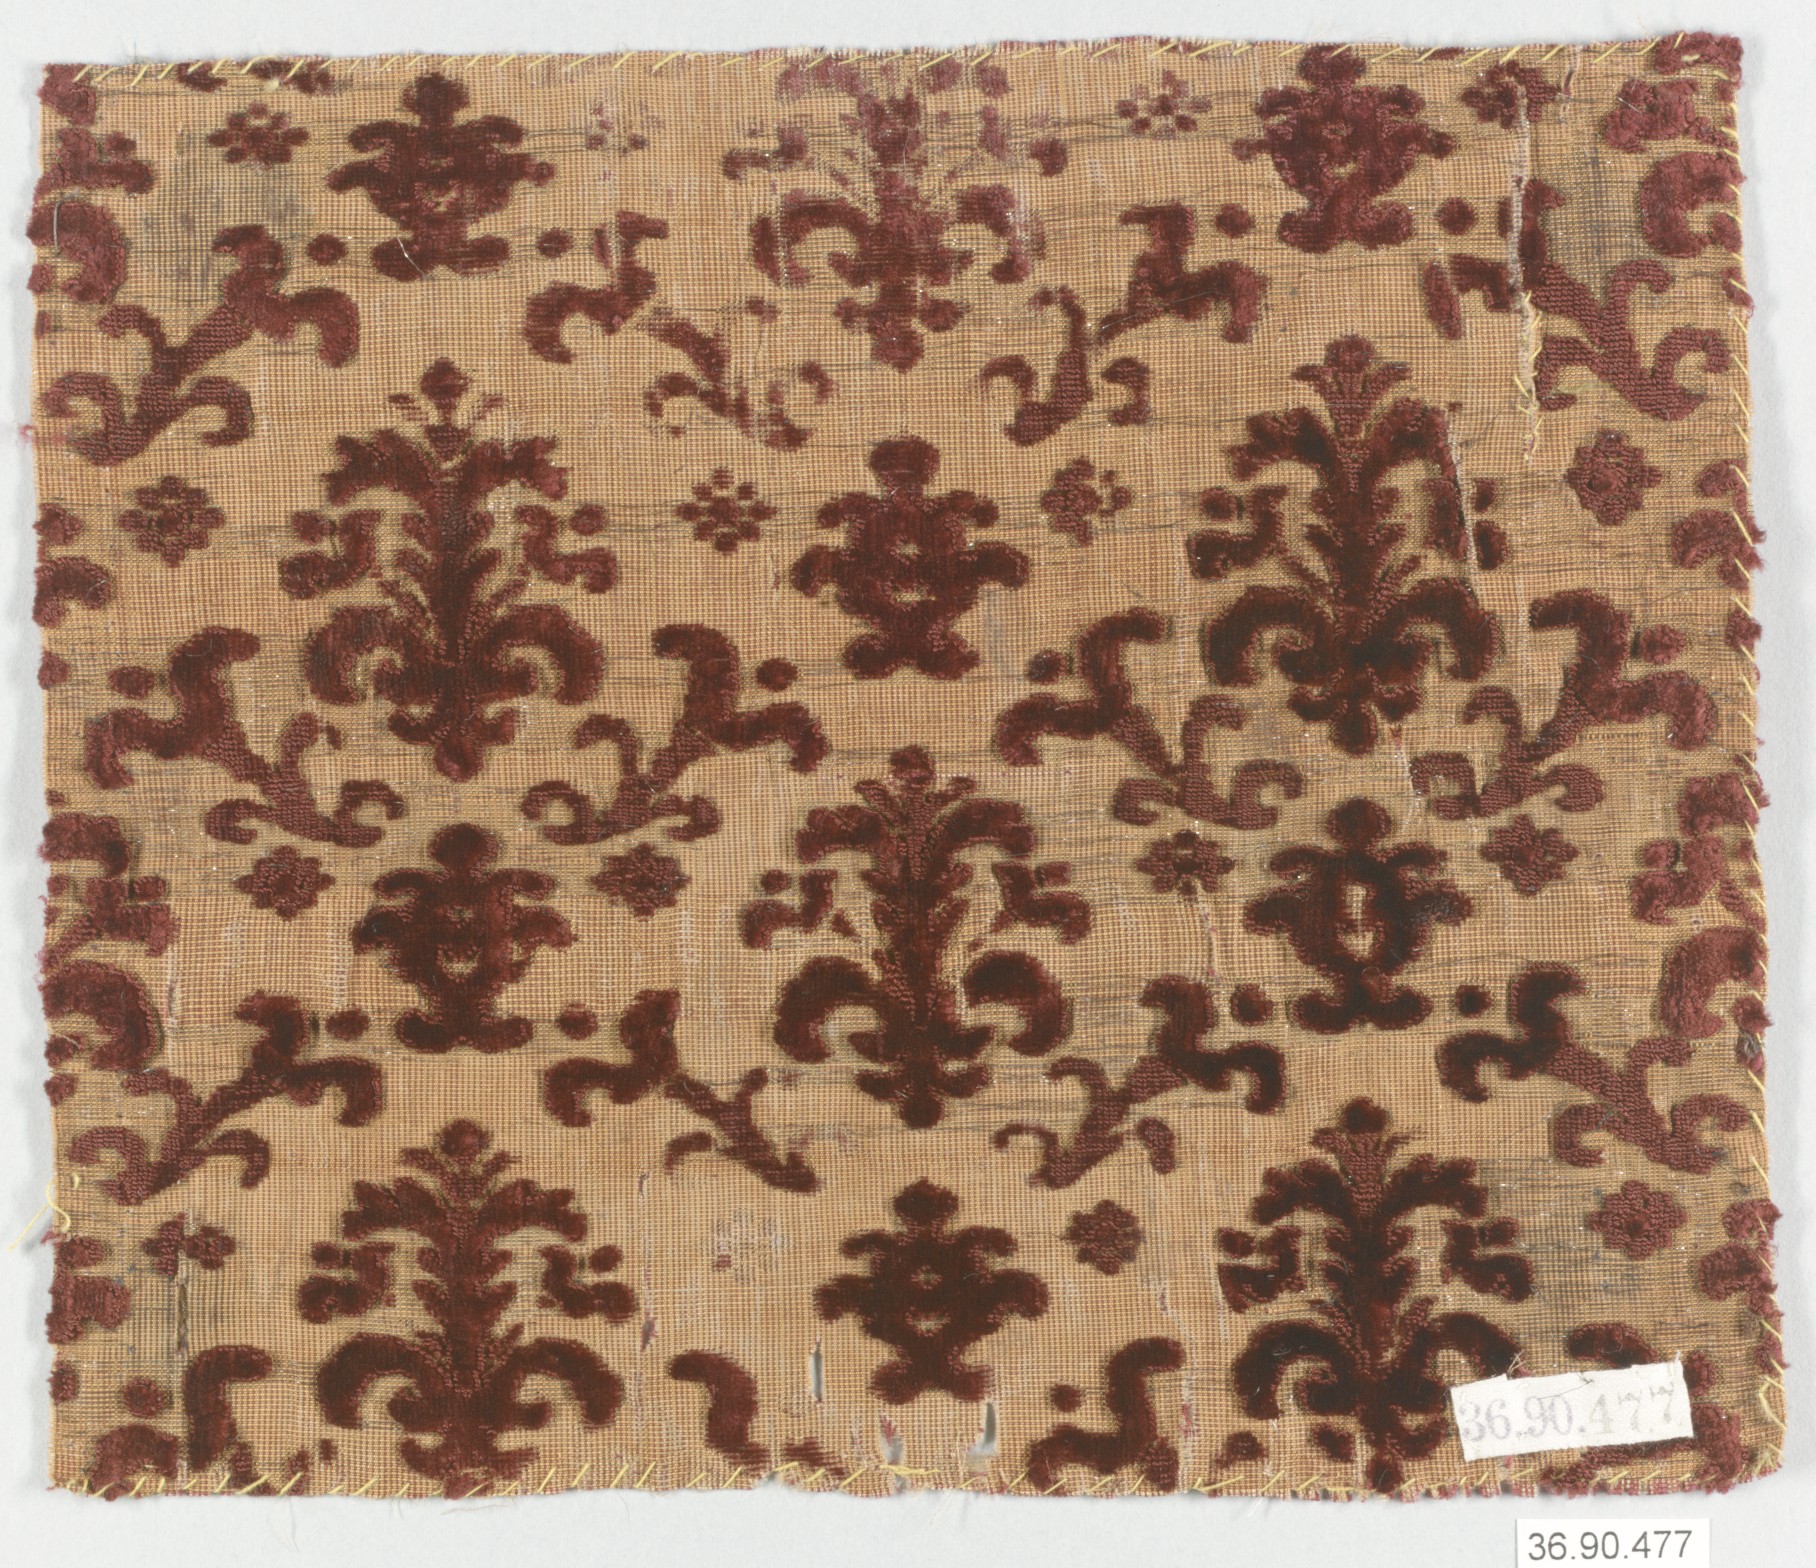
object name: piece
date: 1501-1700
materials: metal thread, silk